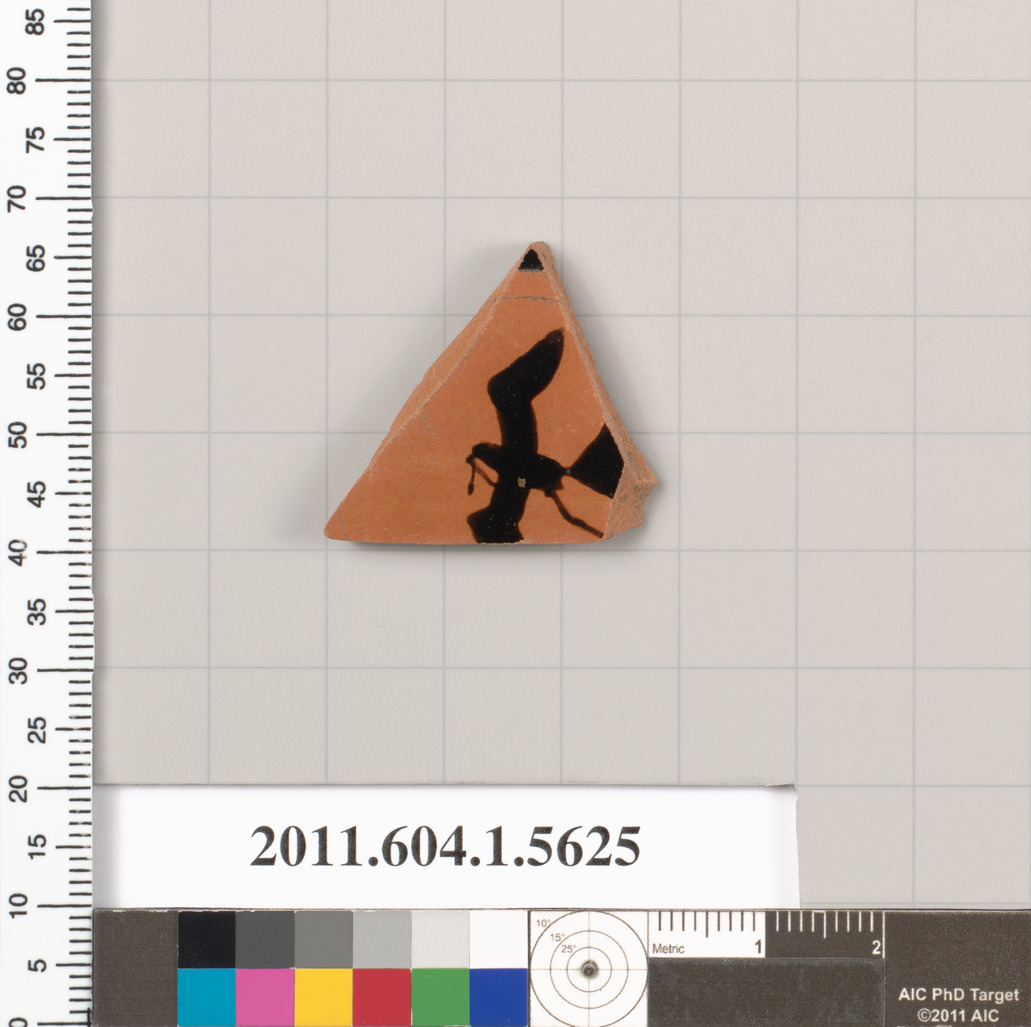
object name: kylix fragment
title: Terracotta fragment of a kylix (drinking cup)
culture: greek, attic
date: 510-490 BCE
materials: terracotta